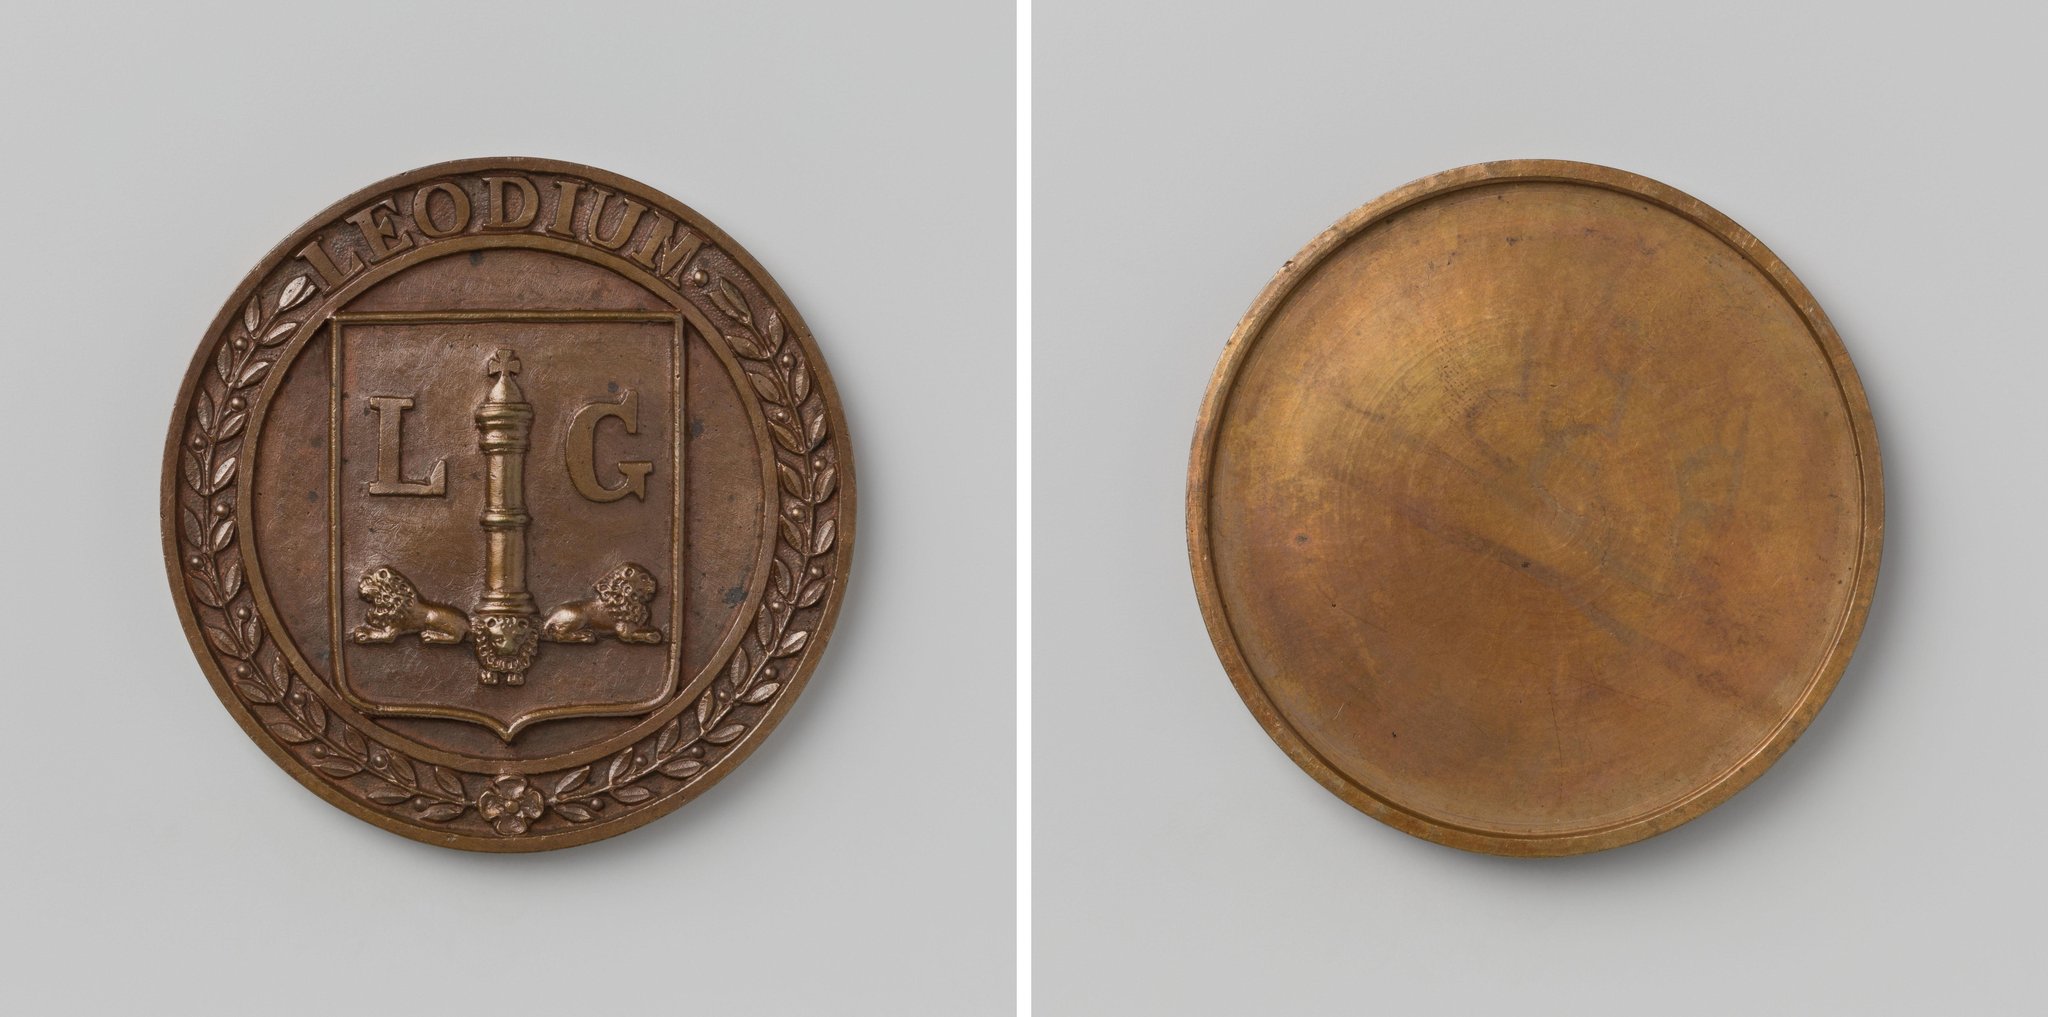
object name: medal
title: Luik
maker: Anonymous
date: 1815-1830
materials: bronze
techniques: striking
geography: netherlands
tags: liège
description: Eenzijdige bronzen penning. Voorzijde: wapenschild binnen omschrift, onderbroken door twee takken. Keerzijde: blanco